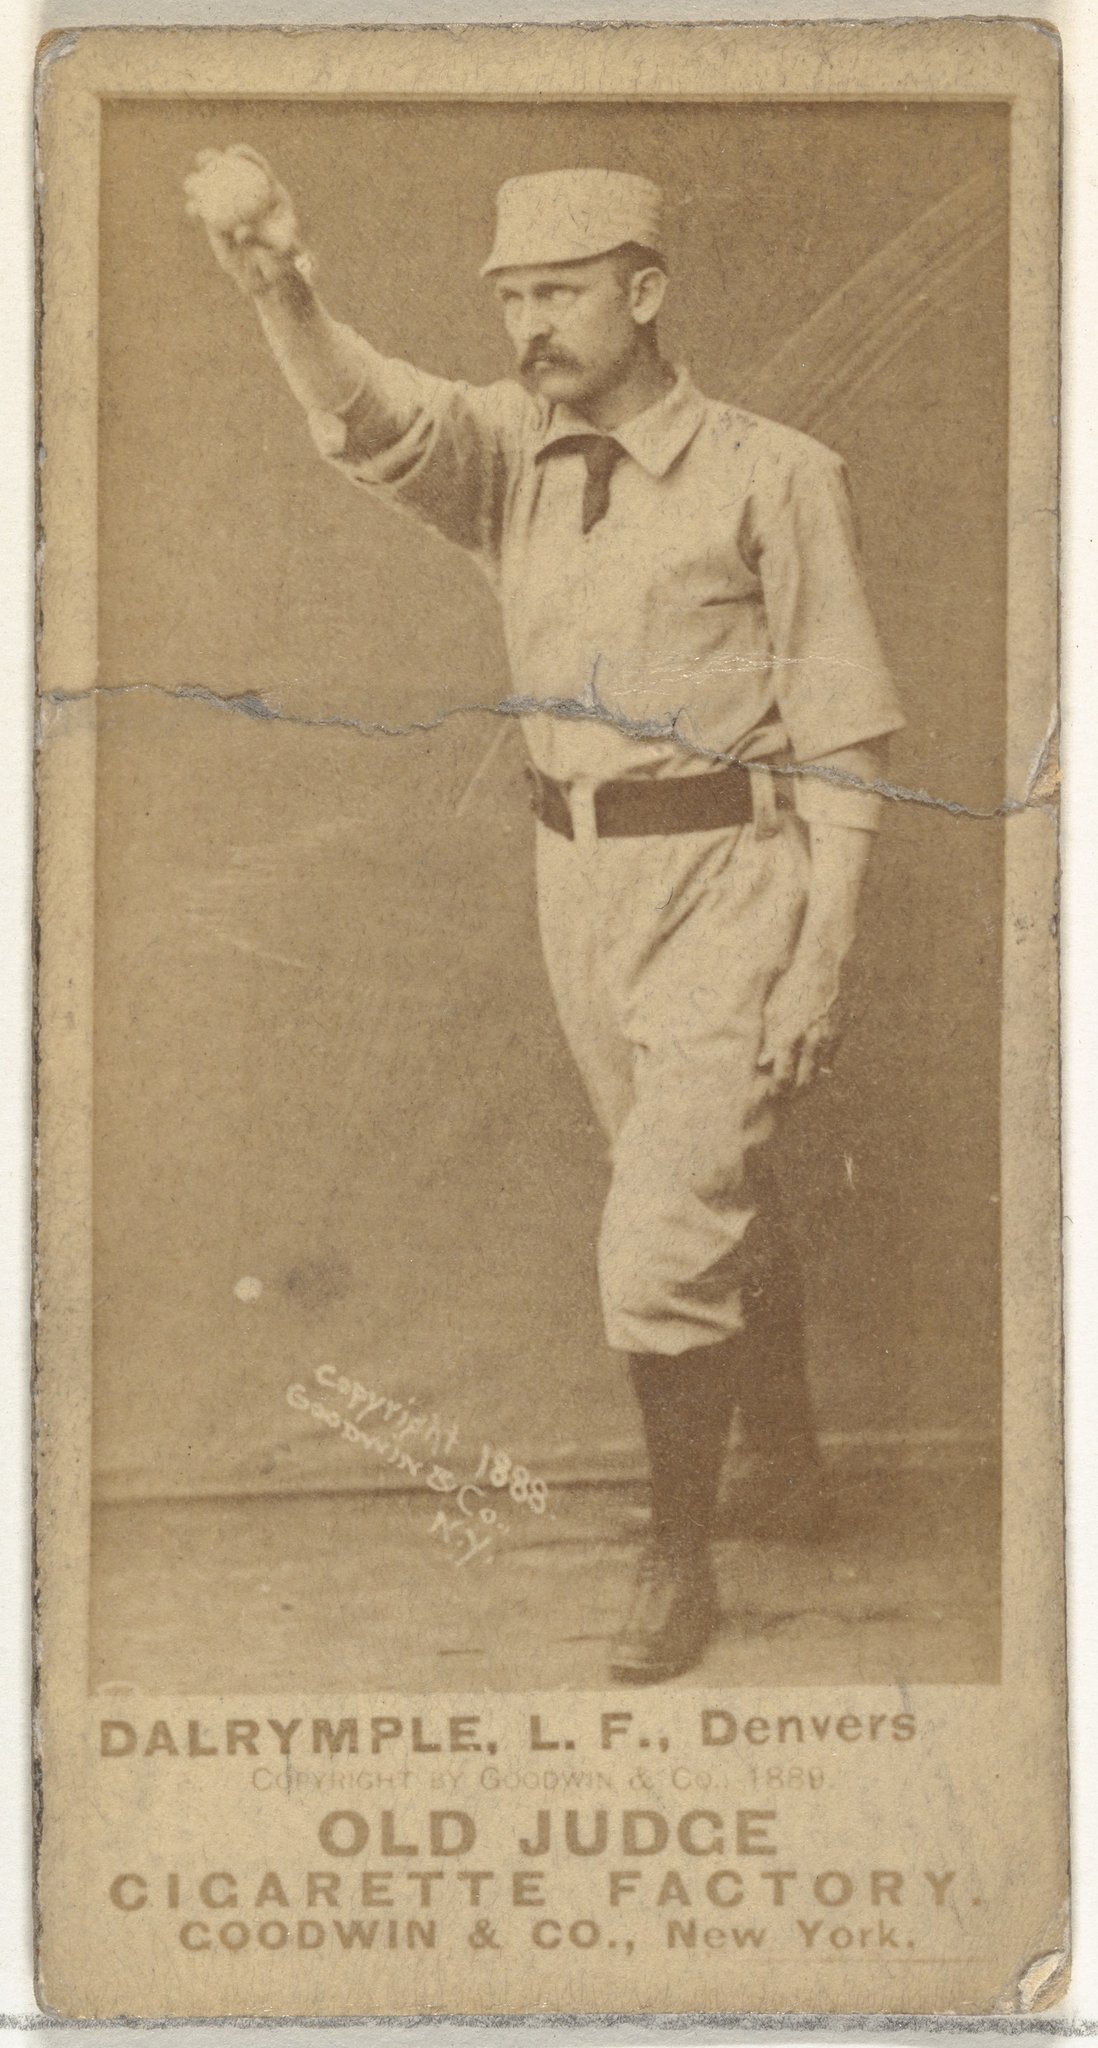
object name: baseball card, photograph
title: Abner Frank Dalrymple, Left Field, Denver, from the Old Judge series (N172) for Old Judge Cigarettes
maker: goodwin & company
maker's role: publisher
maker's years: 1850-1950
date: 1888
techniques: albumen silver print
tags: men,portraits,baseball,athletes